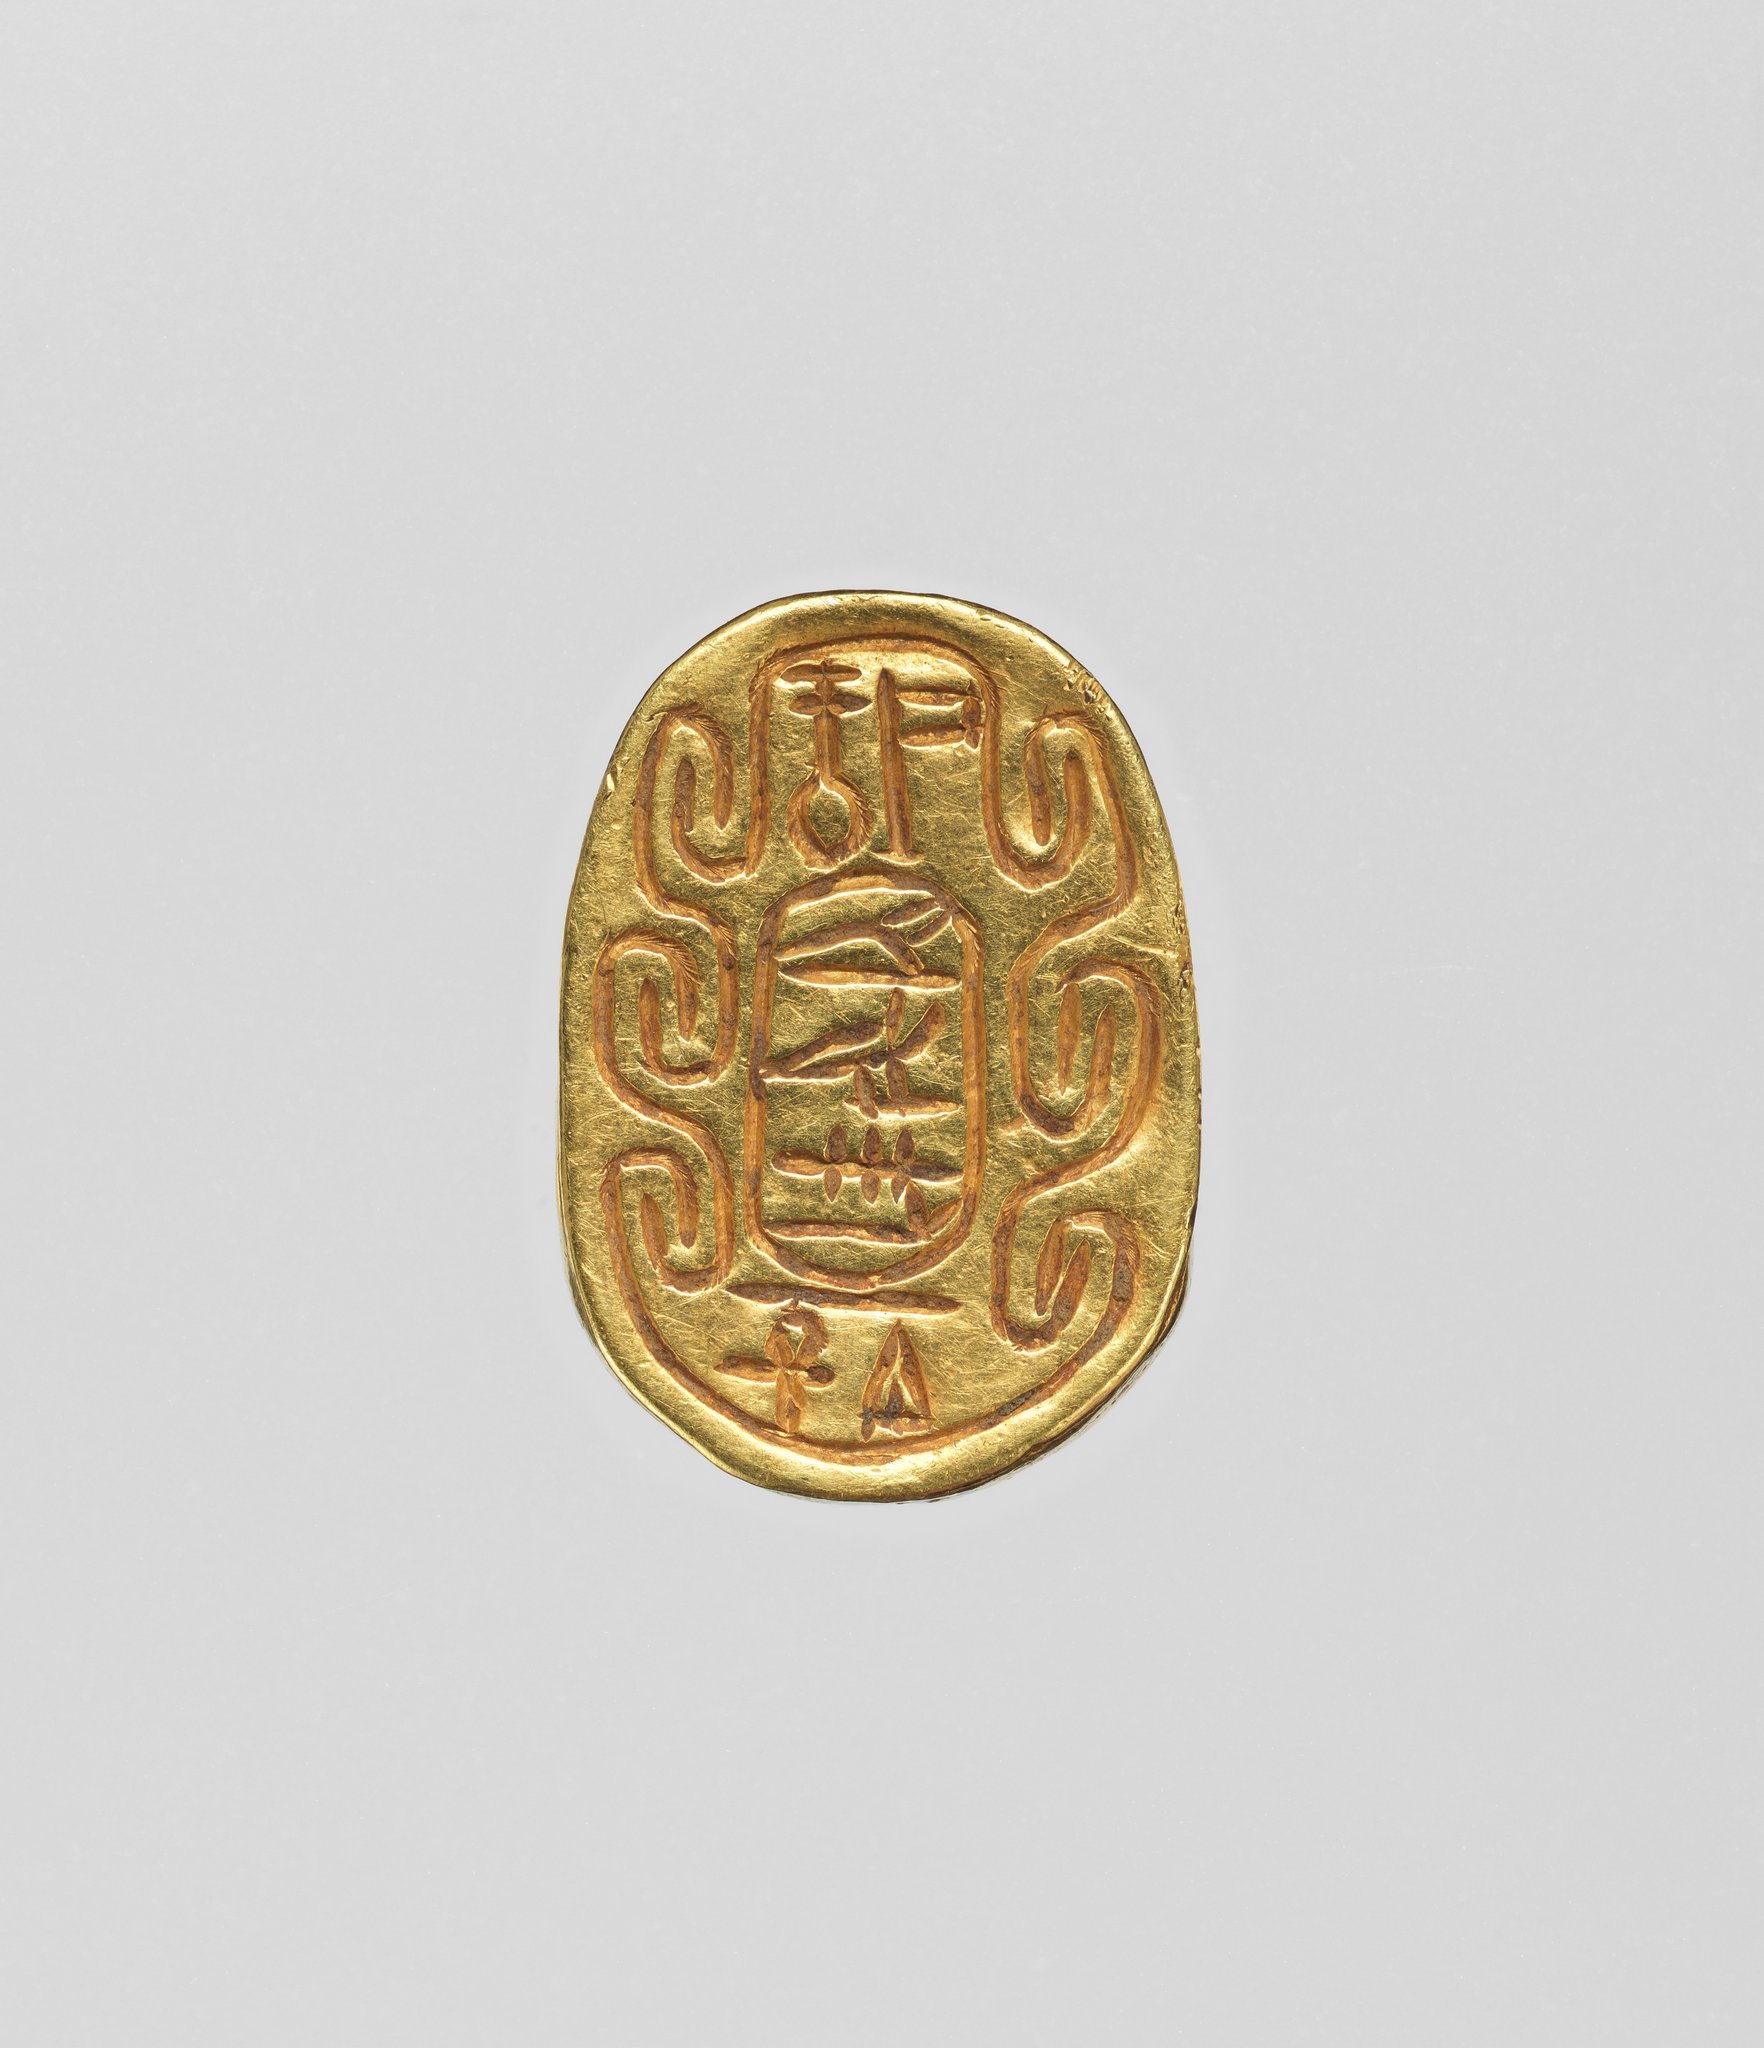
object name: scarab, sebek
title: Scarab Inscribed With the Cartouche of Sebekemsaf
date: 1635-1550 BCE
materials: gold, jasper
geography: egypt